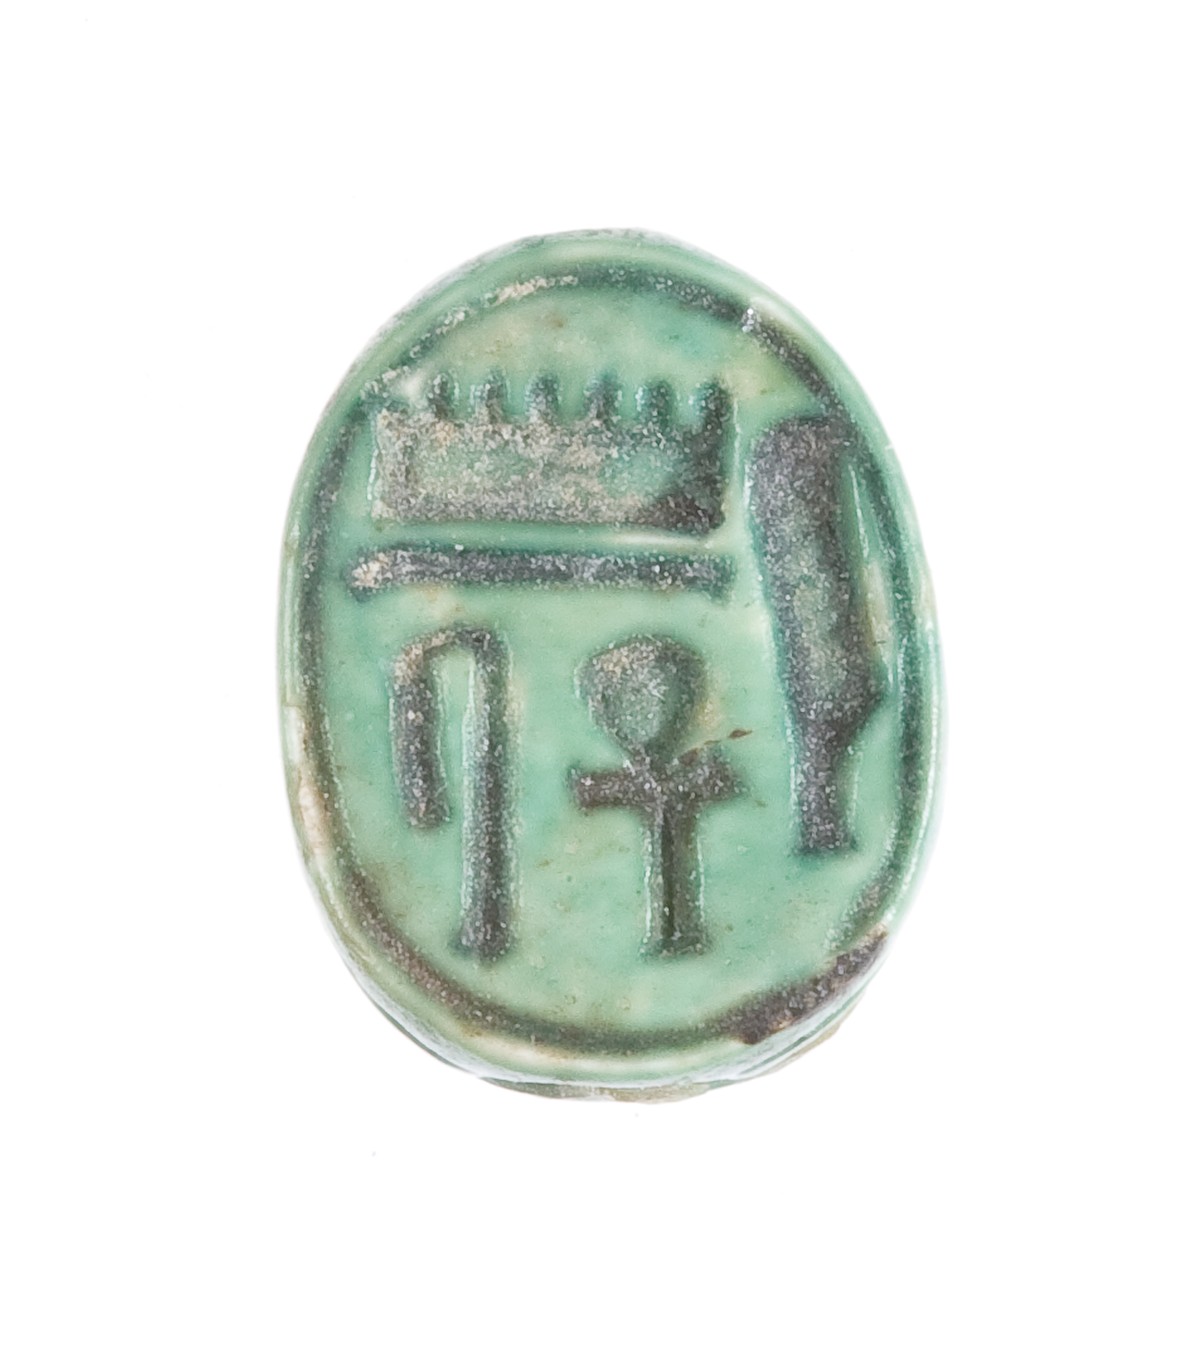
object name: scarab, amun re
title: Scarab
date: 1550-1458 BCE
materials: faience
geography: egypt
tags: hieroglyphs,scarabs